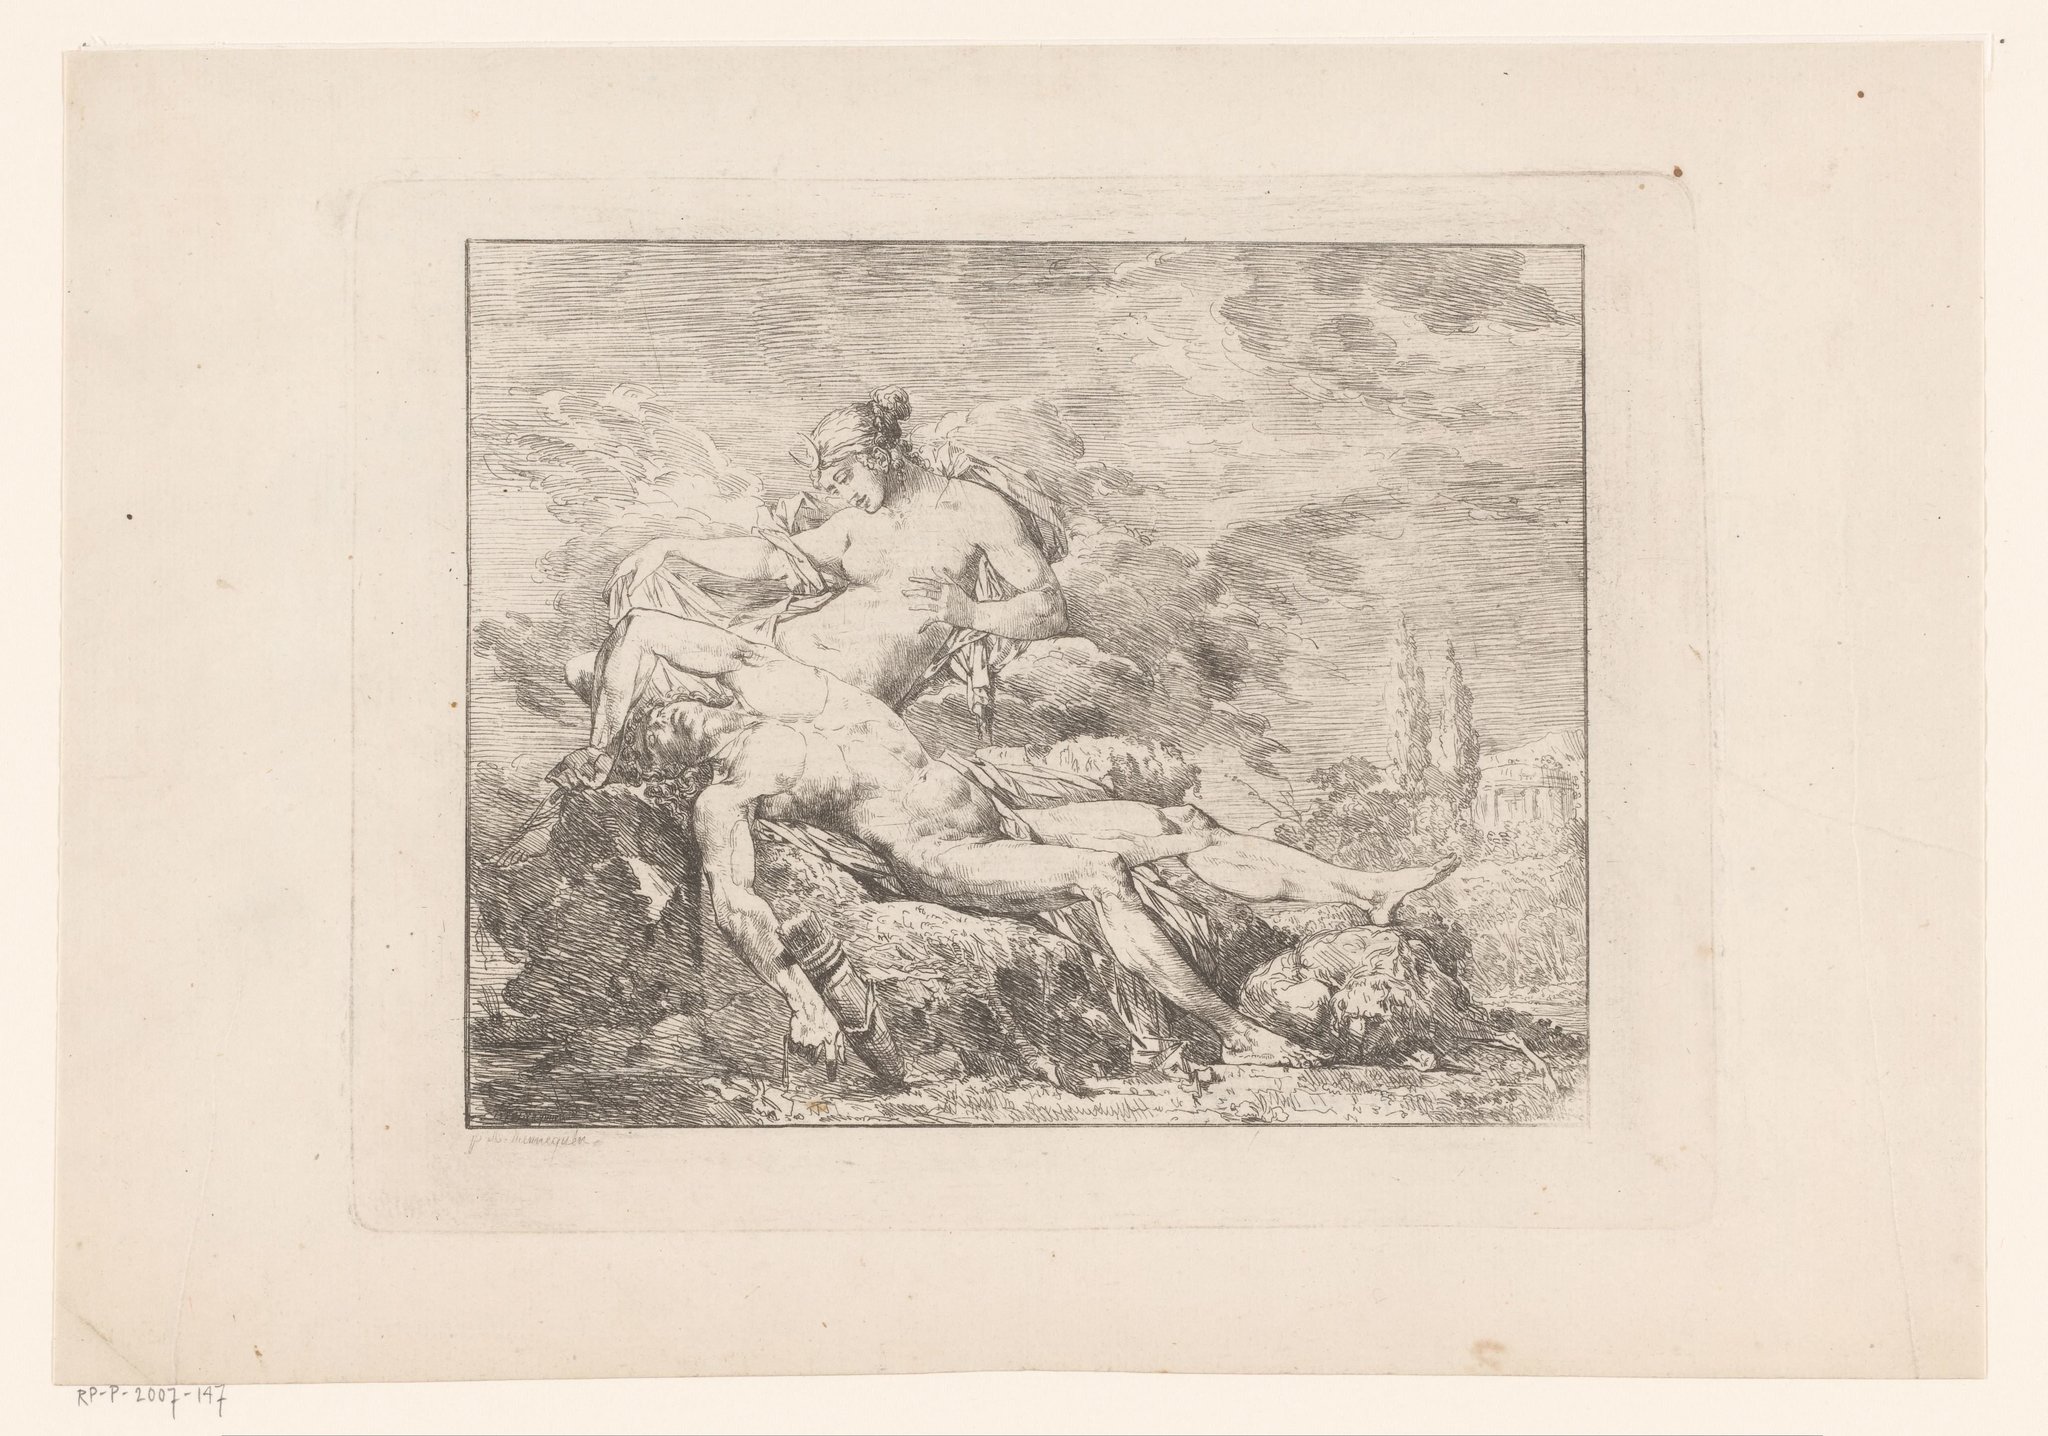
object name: print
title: Diana en Endymion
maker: philippe auguste hennequin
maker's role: draughtsman, print maker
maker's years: 1762-1833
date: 1772-1833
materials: paper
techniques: etching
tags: diana (luna) visiting the sleeping endymion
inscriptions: collector's mark: Lugt 2760, collector's mark: Lugt 2228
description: Diana buigt zich over de naakte Endymion, die op de grond ligt te slapen. Naast hem zijn pijlenkoker en aan zijn voeten een slapende hond. Rechts op de achtergrond een klassieke tempel.